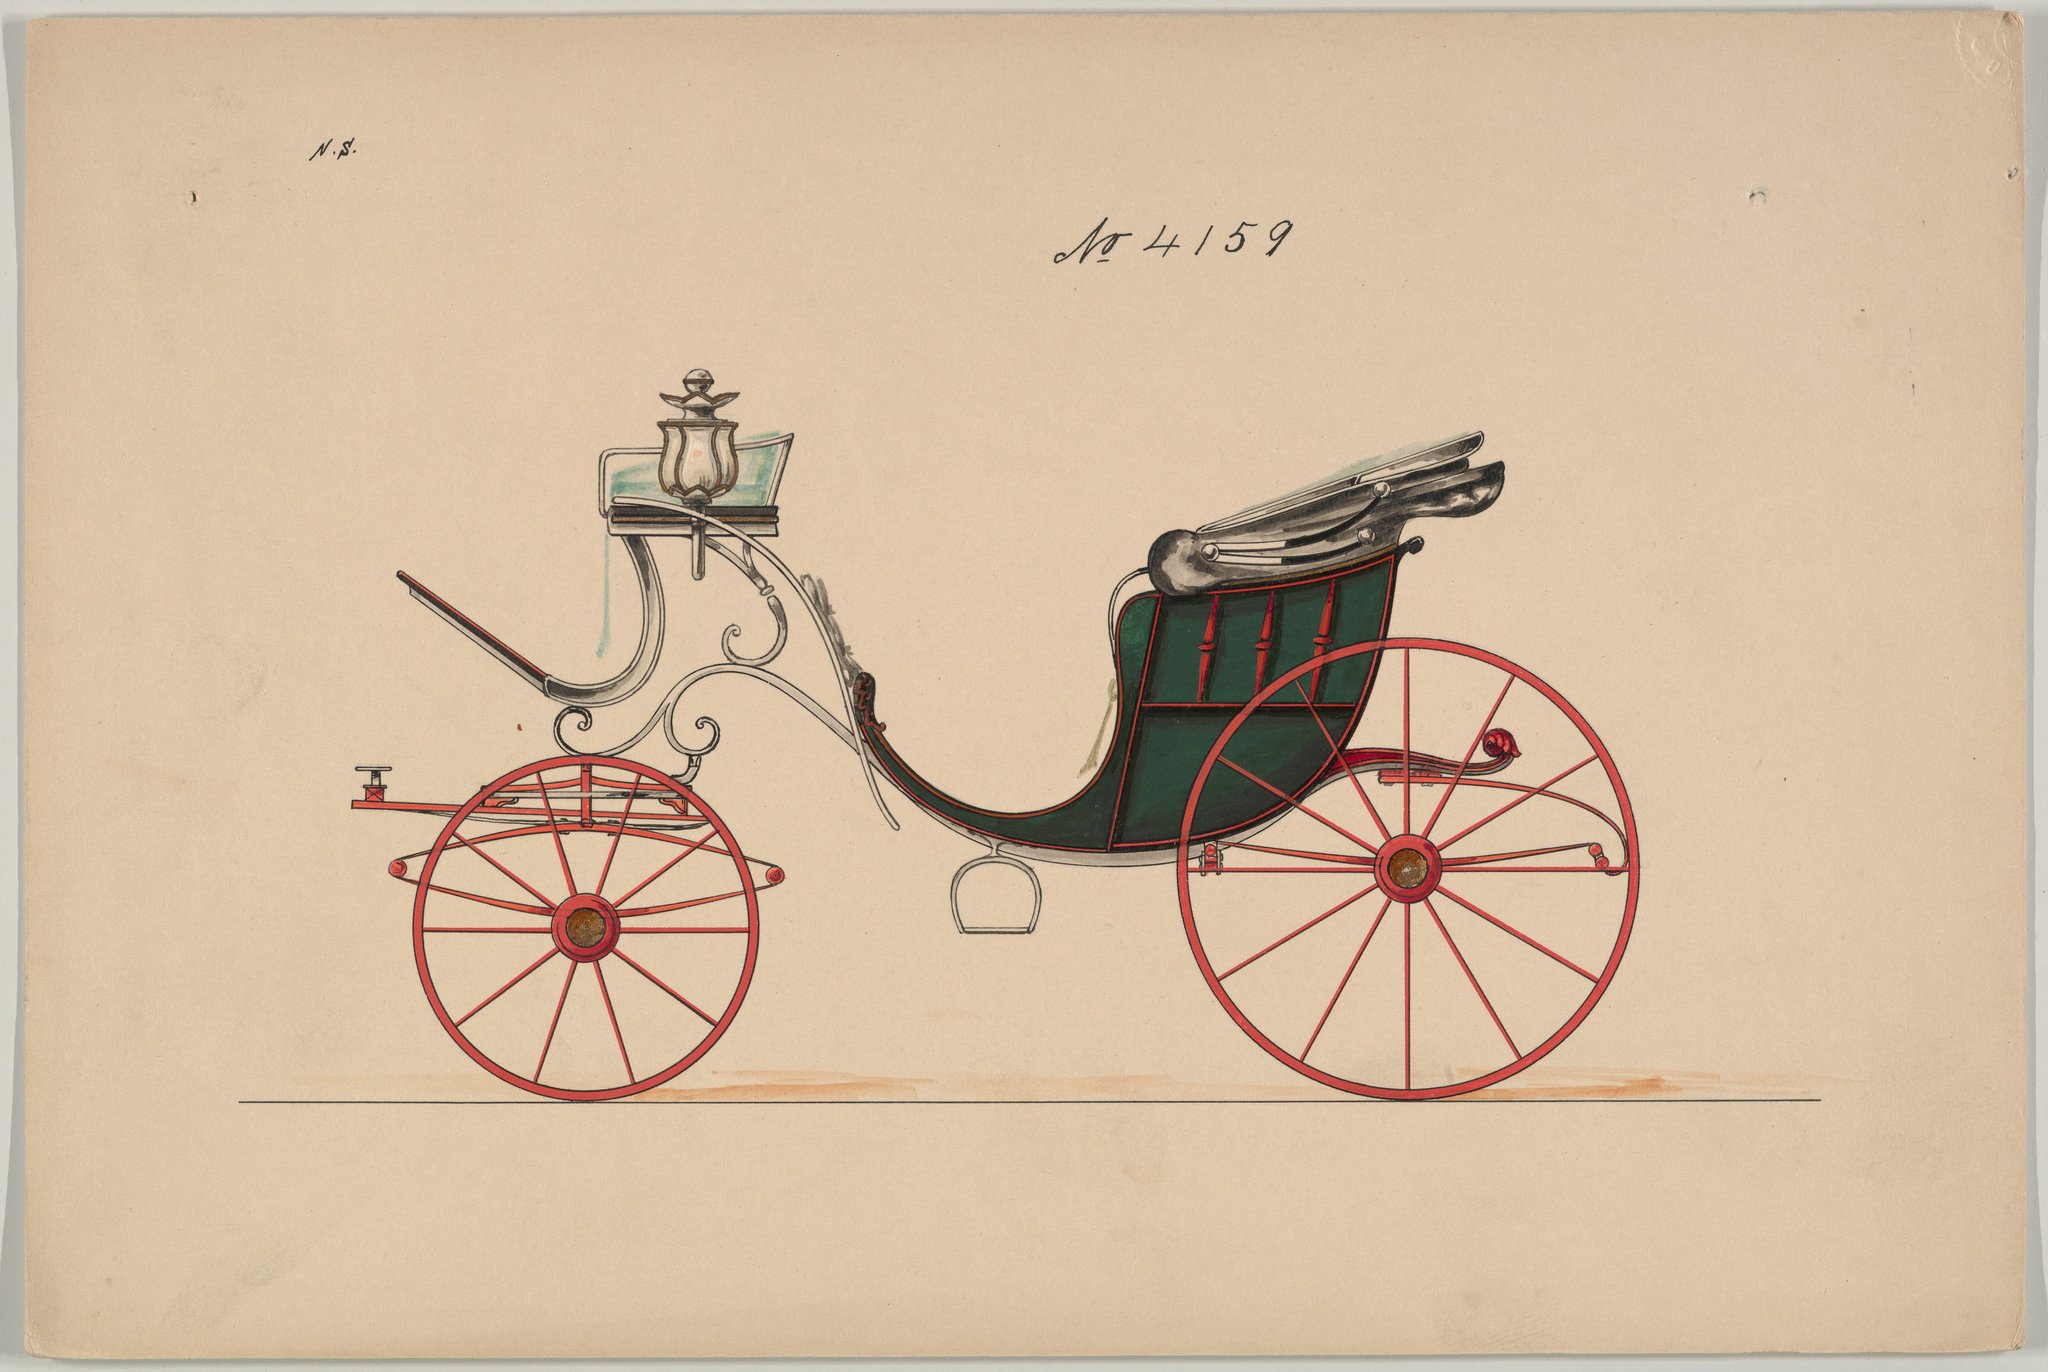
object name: drawing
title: Design for Cabriolet or Victoria, no. 4159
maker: brewster & co.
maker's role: manufacturer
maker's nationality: american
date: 1892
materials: gouache, gum arabic, ink, watercolor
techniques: pen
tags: carriages